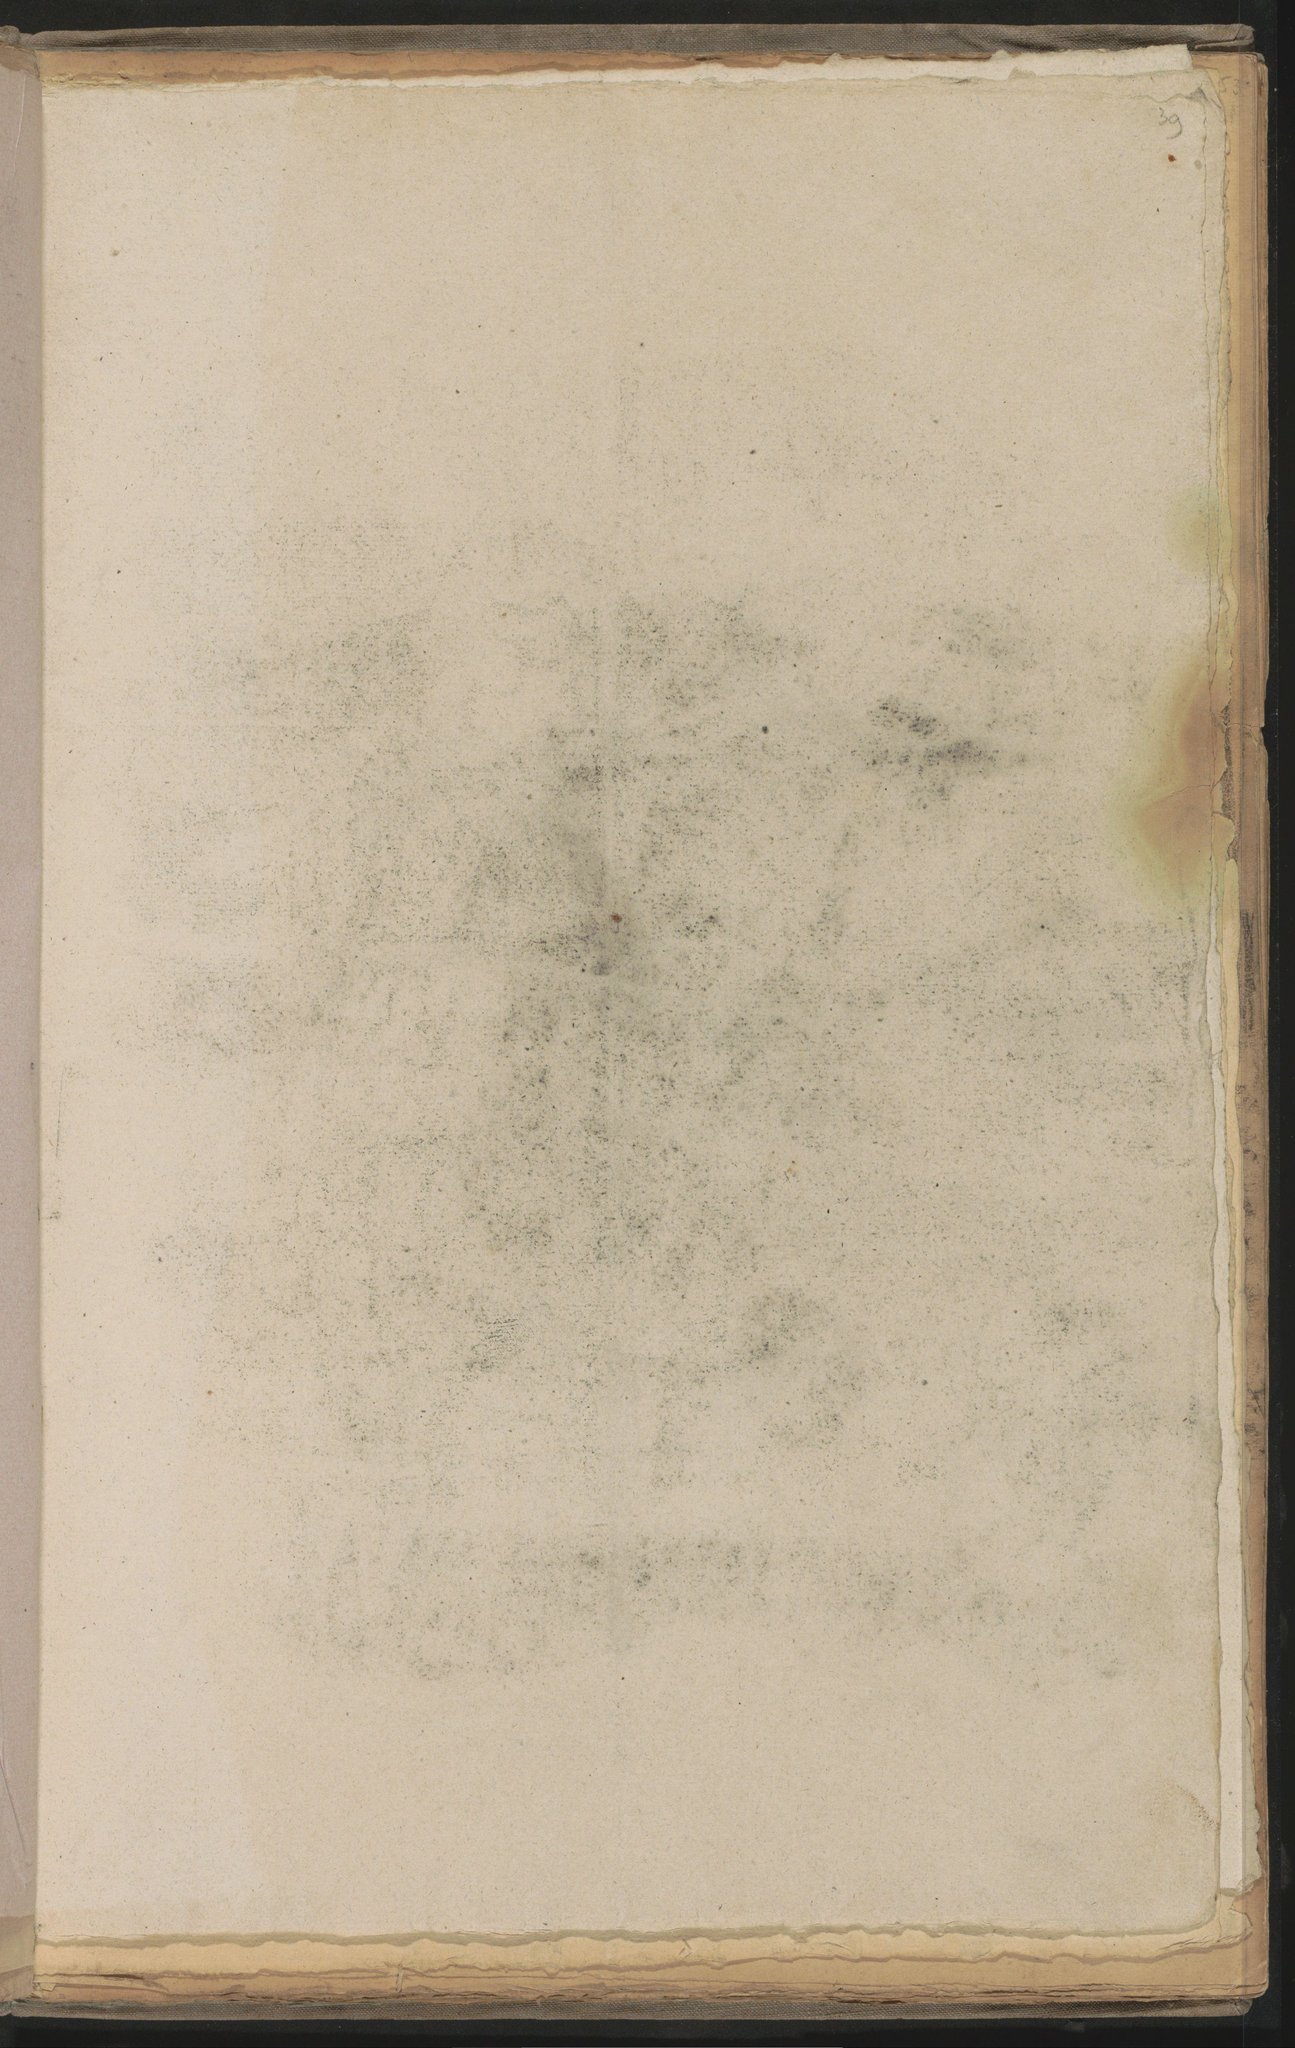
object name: sketchbook leaf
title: Abklatsch van de krijttekening op pagina 38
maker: willem witsen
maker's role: draughtsman, painter, print maker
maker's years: 1860-1923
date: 1884-1887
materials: paper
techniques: printmaking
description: Pagina 39 uit een schetsboek met 42 bladen vervaardigd rond de Ewijkshoeve.